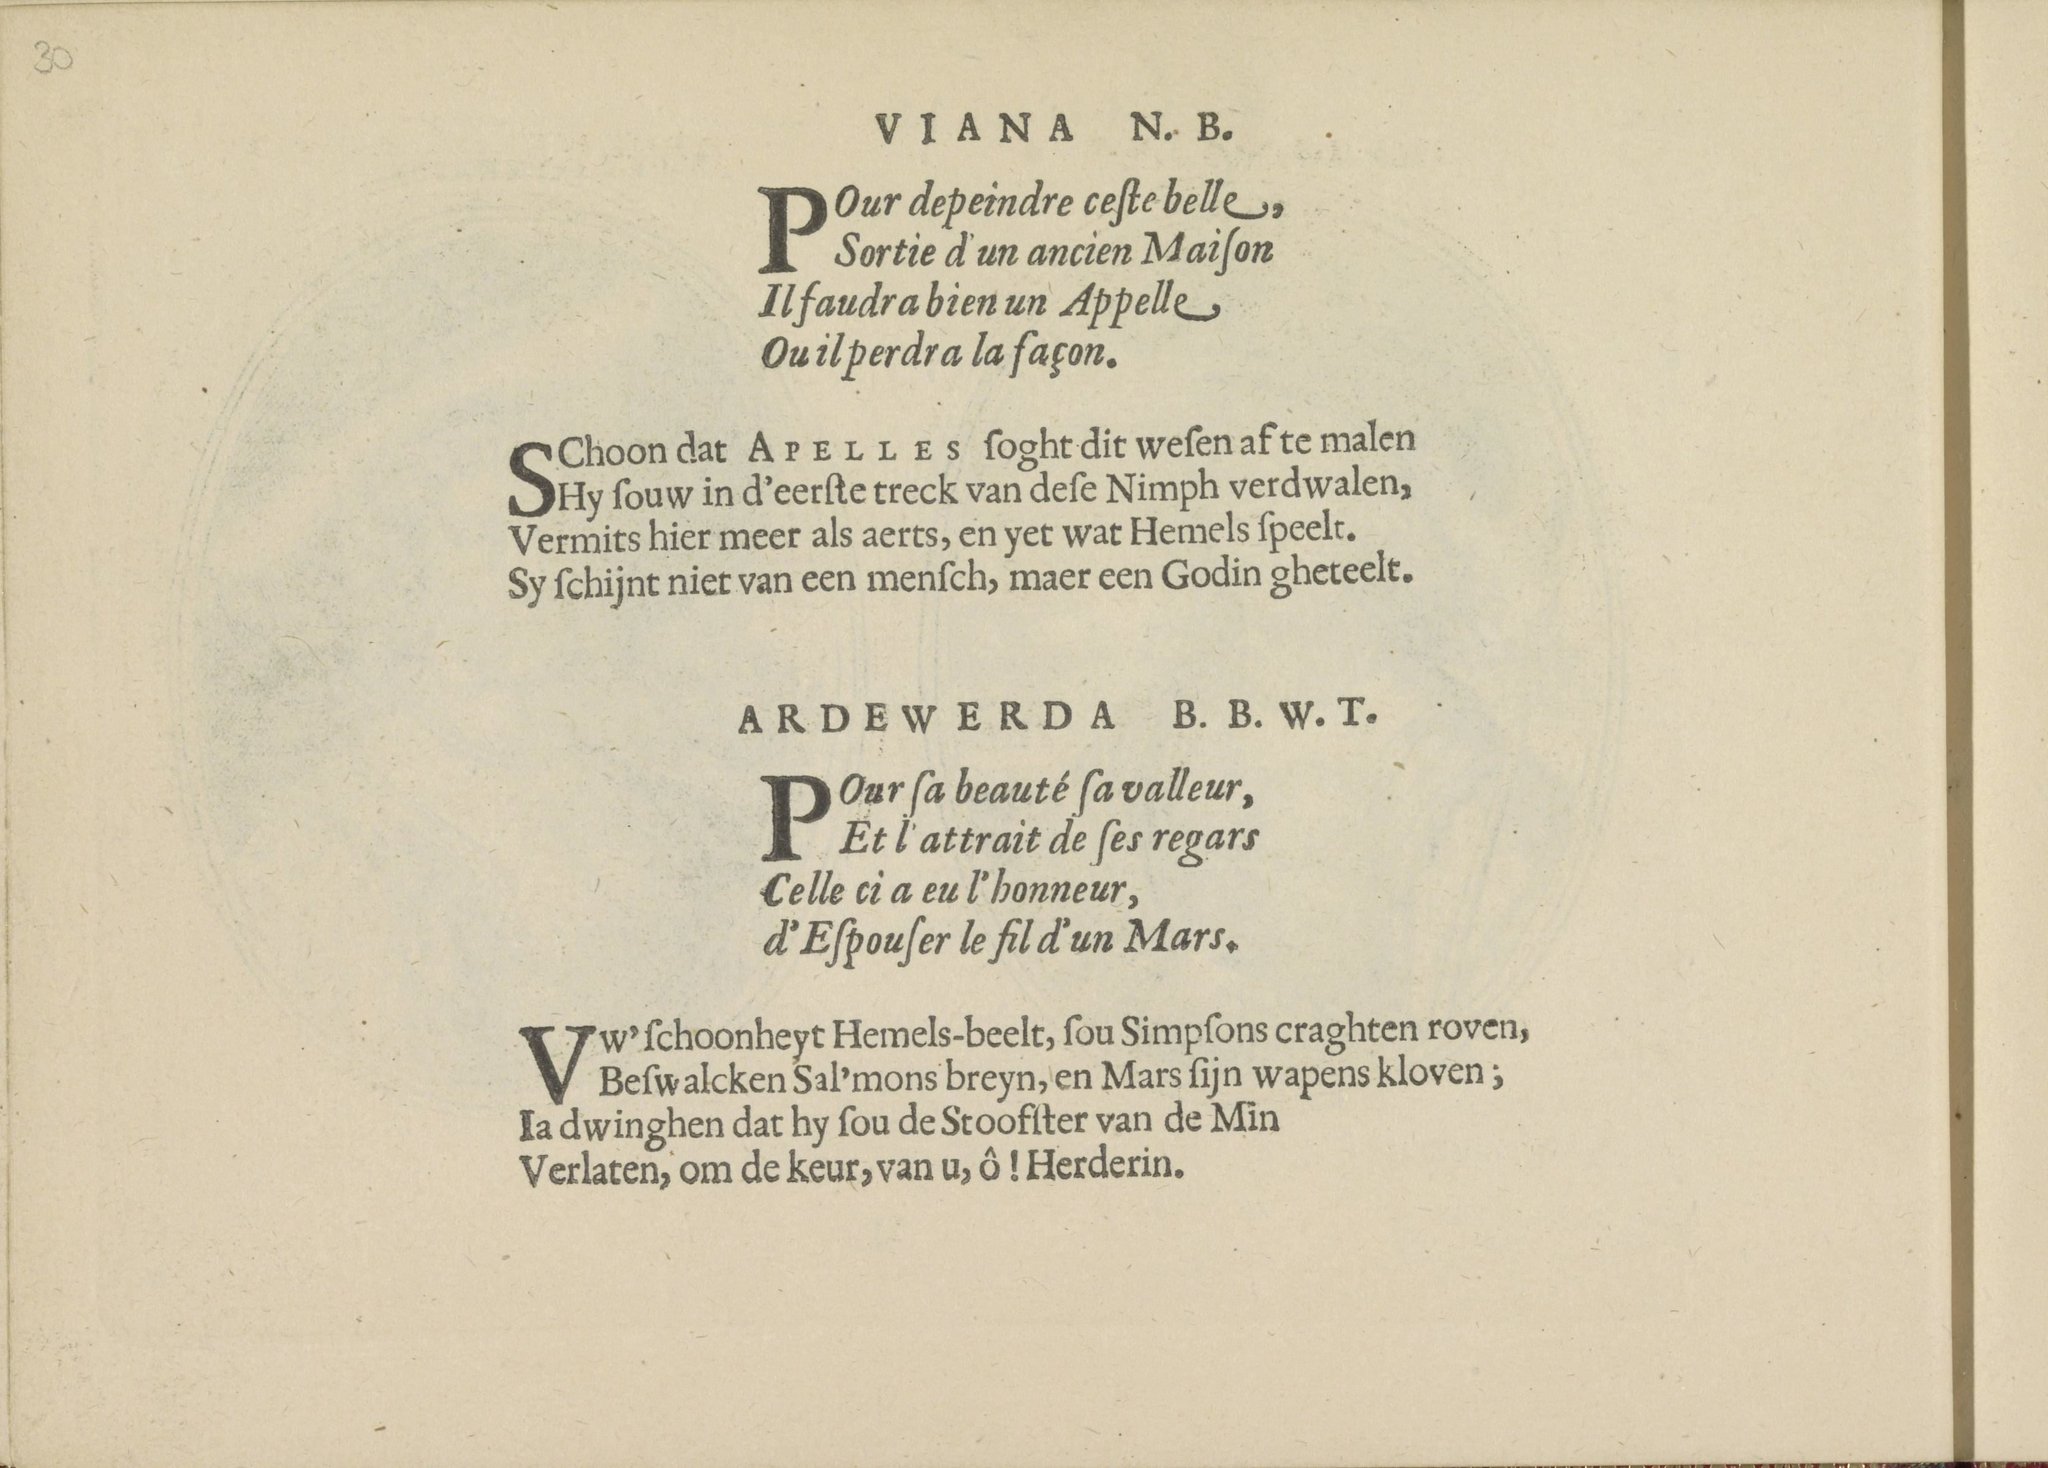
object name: text sheet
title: Kwatrijnen bij de voorstellingen van Viana N.B. en Ardewerda B.B.W.T.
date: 1640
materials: paper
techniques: letterpress printing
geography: amsterdam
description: Twee keer twee kwatrijnen in het Frans en Nederlands bij de voorstellingen van Viana N.B. en Ardewerda B.B.W.T. Het blad maakt deel uit van een album.